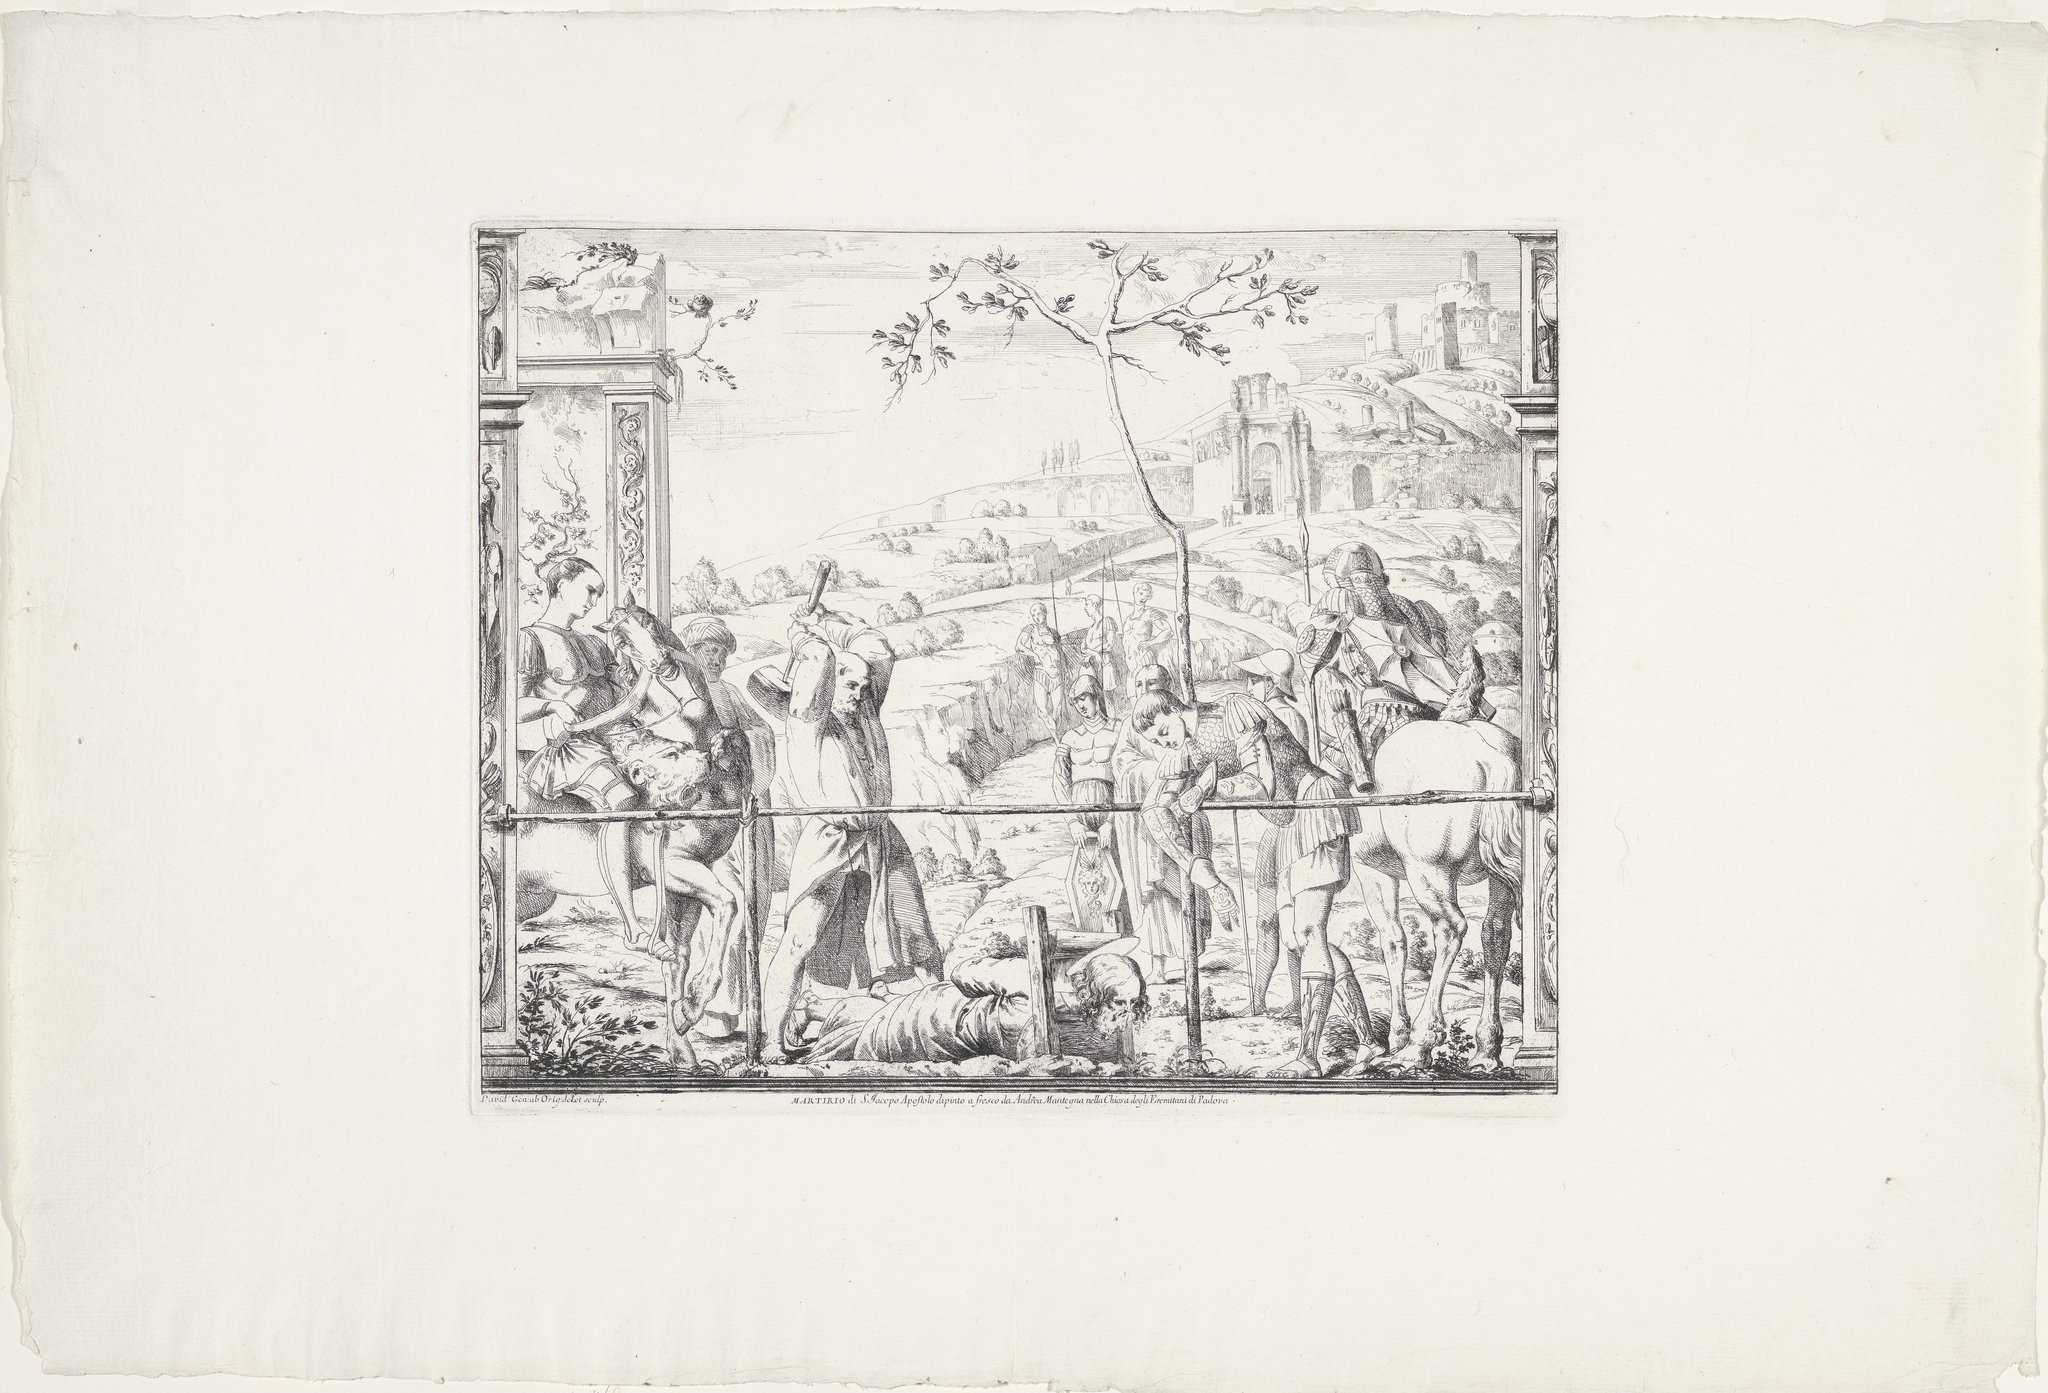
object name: print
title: De fresco's van Andrea Mantegna in de Chiesa degli Eremitani in Padua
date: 1776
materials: paper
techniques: etching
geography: italy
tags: beheading of james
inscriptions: collector's mark: Lugt 2228, collector's mark: Lugt 2760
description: Prent uit een reeks van vier prenten (+ titelprent) met weergaven van de fresco's van Andrea Mategna in de Chiesa degli Eremitani in Padua (fresco's zijn vernietigd tijdens bombardement 11 maart 1944).